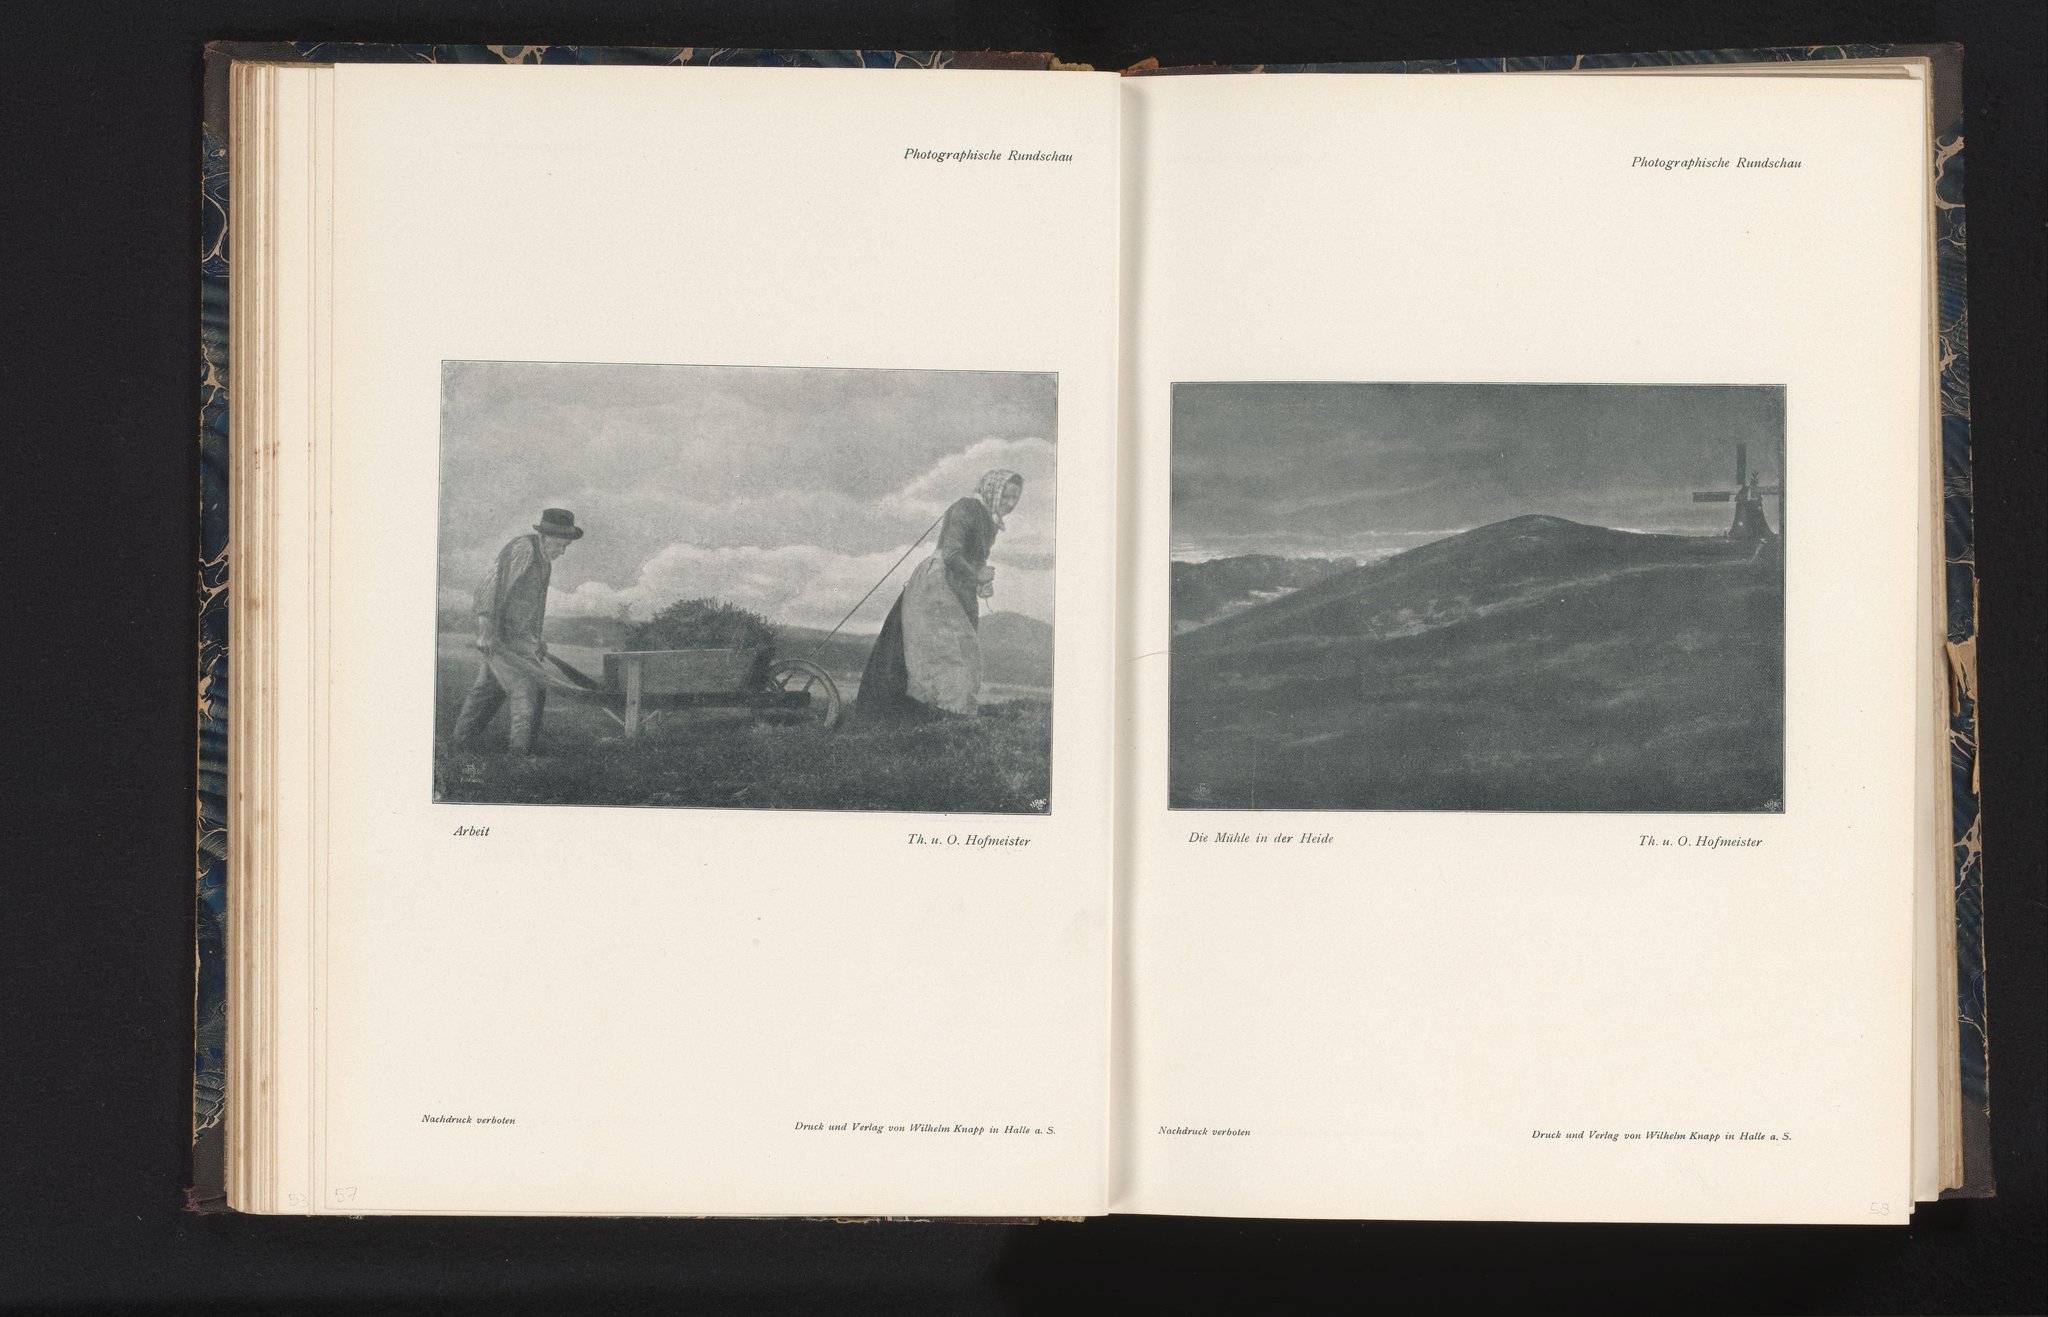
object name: photomechanical print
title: Gezicht op een molen op een heuvel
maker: th. u. o. hofmeister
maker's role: fotograaf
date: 1897-1902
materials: paper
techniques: autotype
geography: berlin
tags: landscapes, windmill